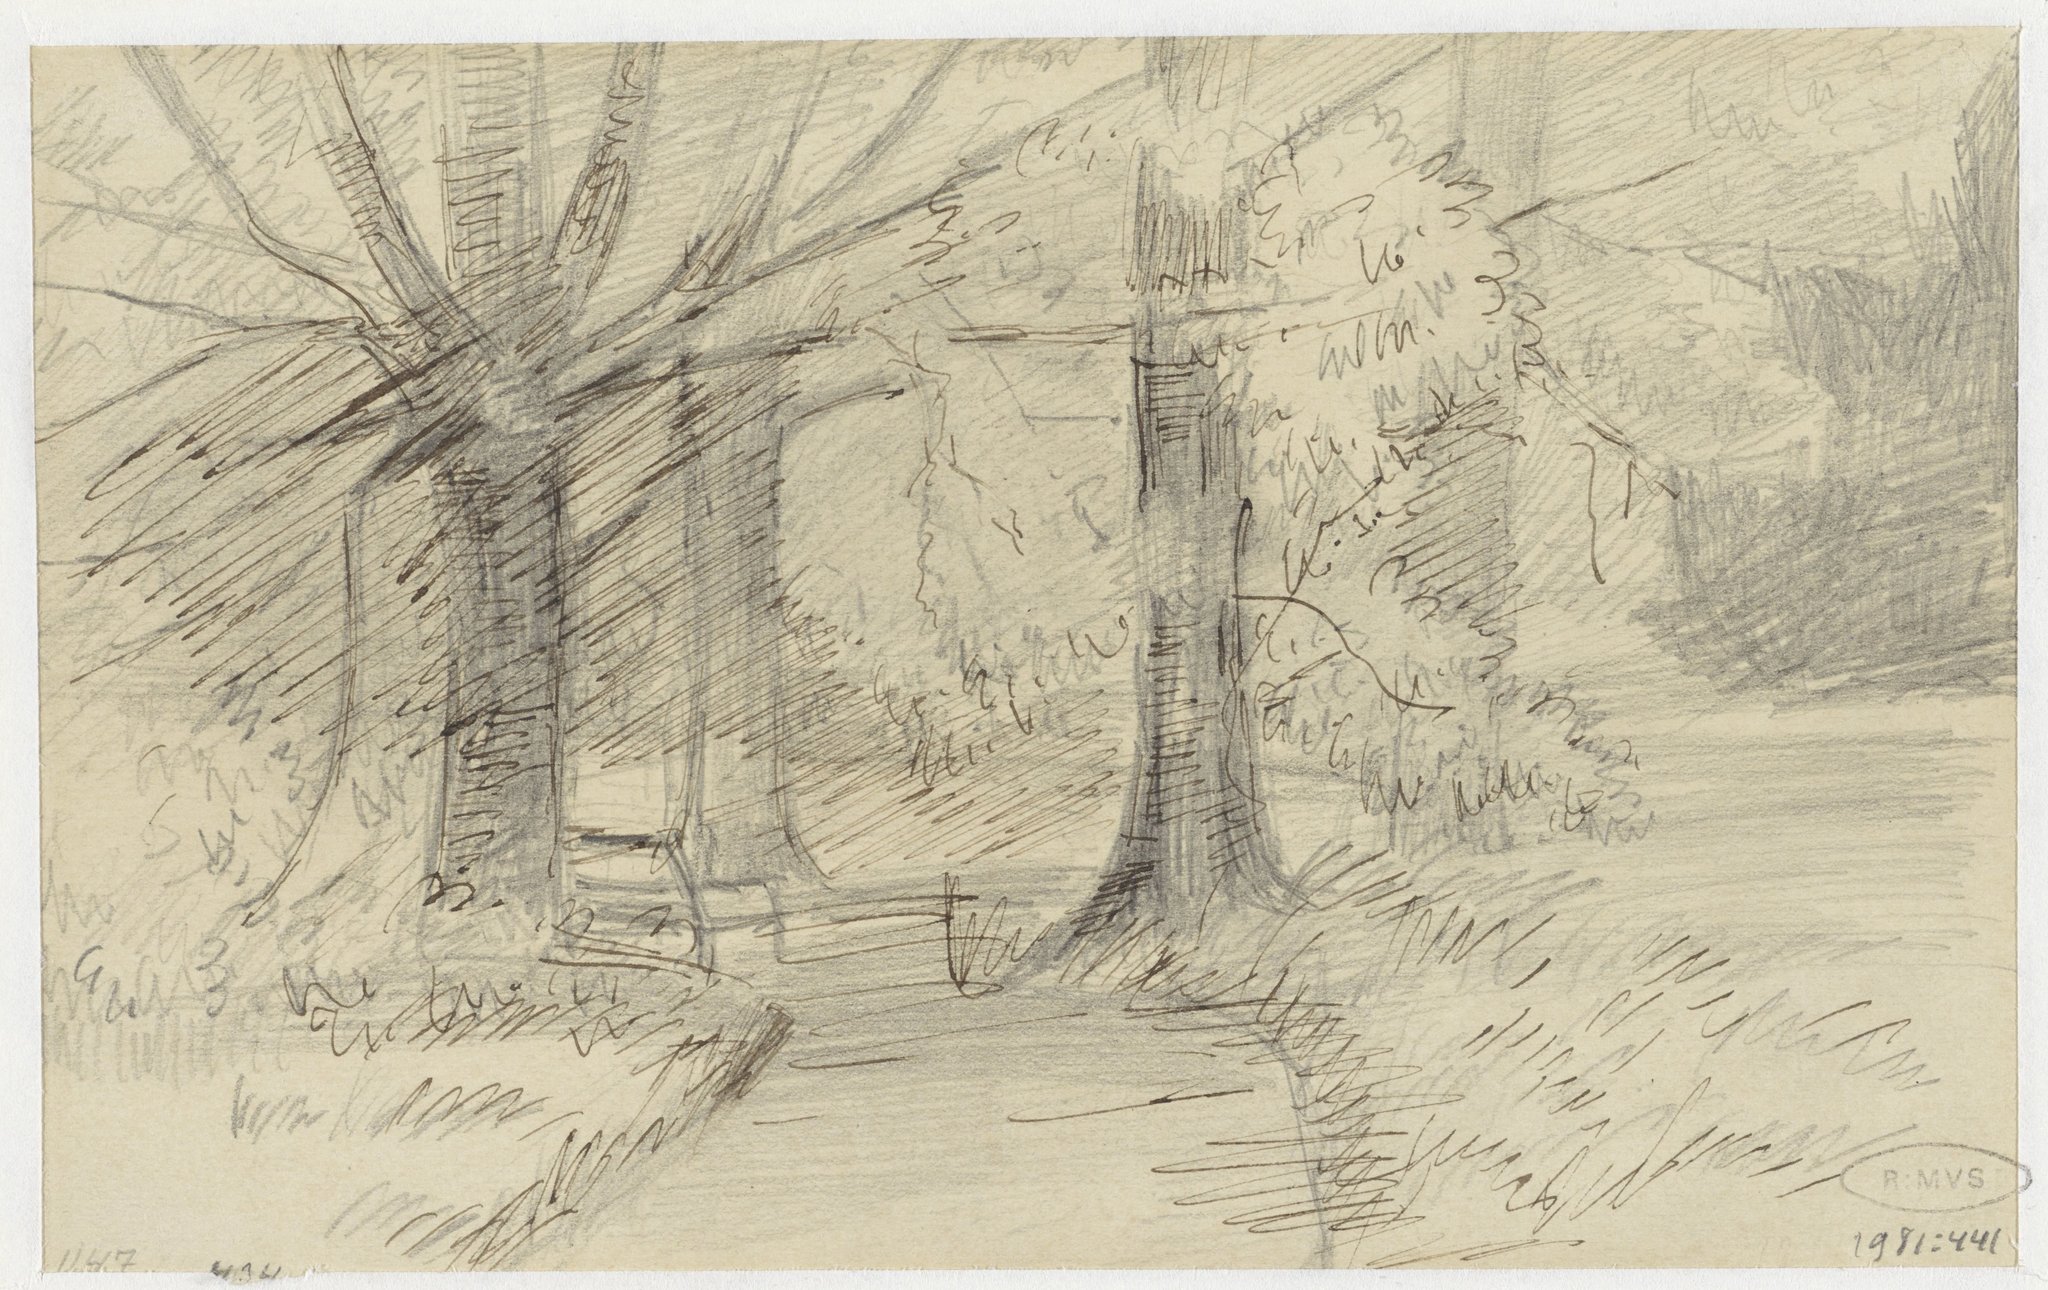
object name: drawing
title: Park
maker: jozef israëls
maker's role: draughtsman, painter, print maker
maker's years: 1824-1911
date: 1834-1911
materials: ink, paper, pencil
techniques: pen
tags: public gardens, park